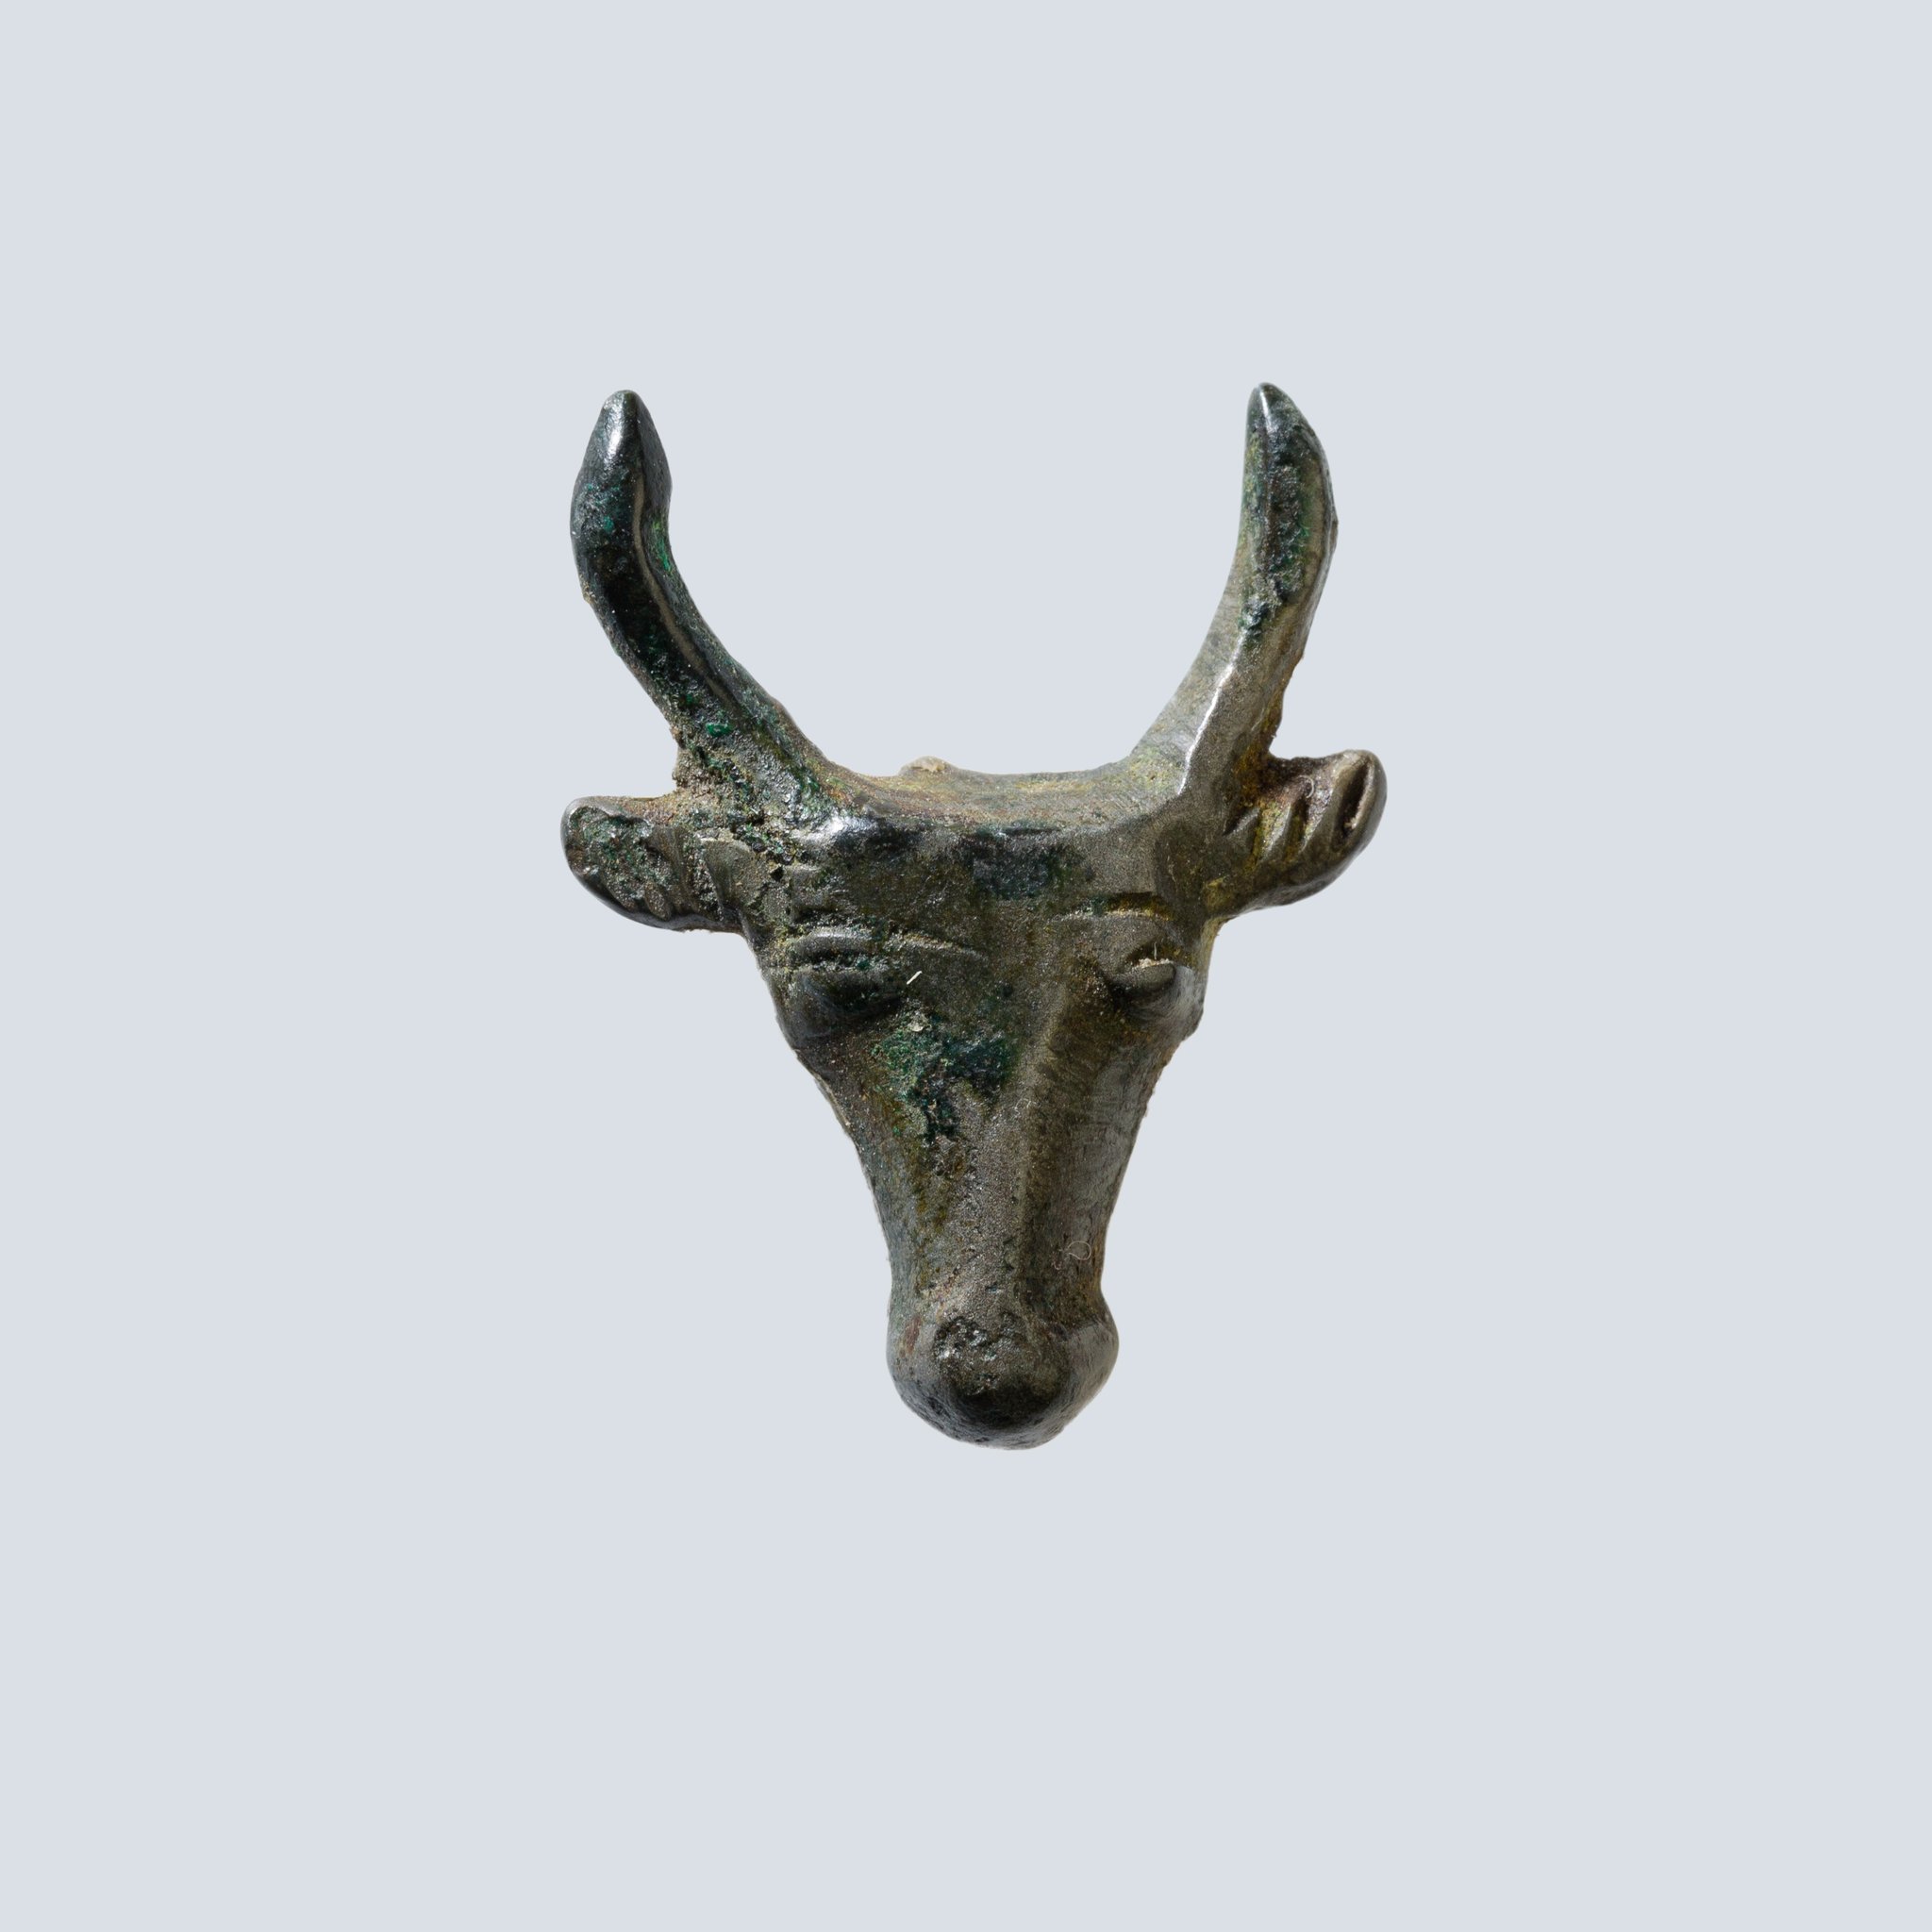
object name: amulet, bull head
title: Bull's head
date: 664-630 BCE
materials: metal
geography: egypt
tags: bulls